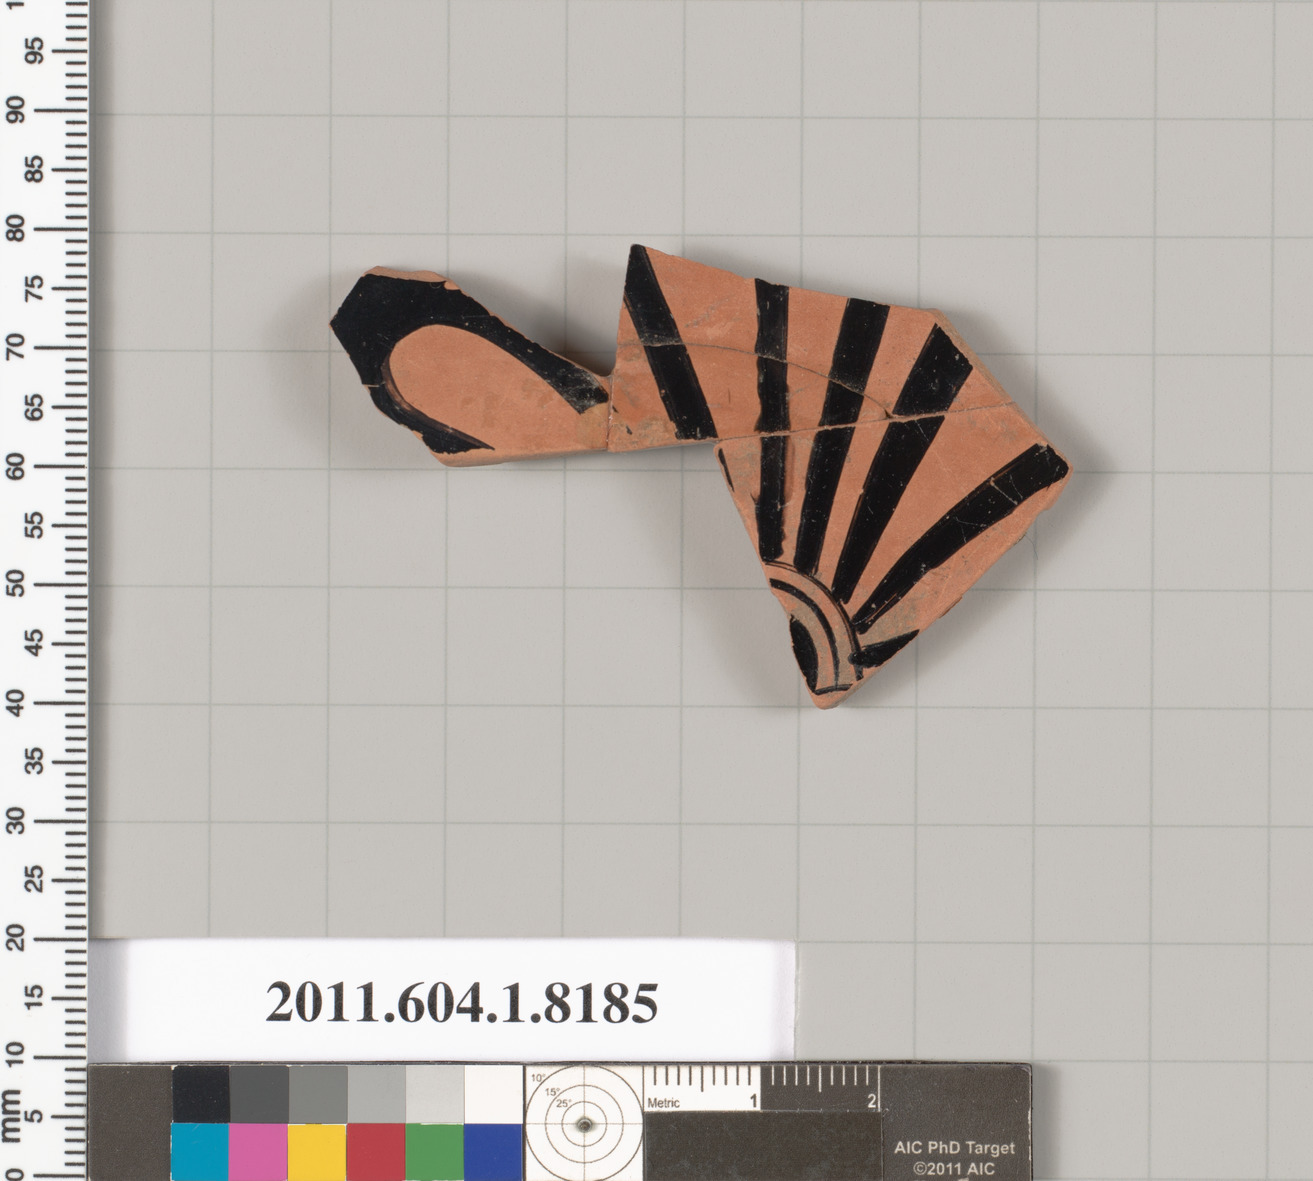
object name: kylix fragment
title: Terracotta fragment of a kylix (drinking cup)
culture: greek, attic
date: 520-500 BCE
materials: terracotta